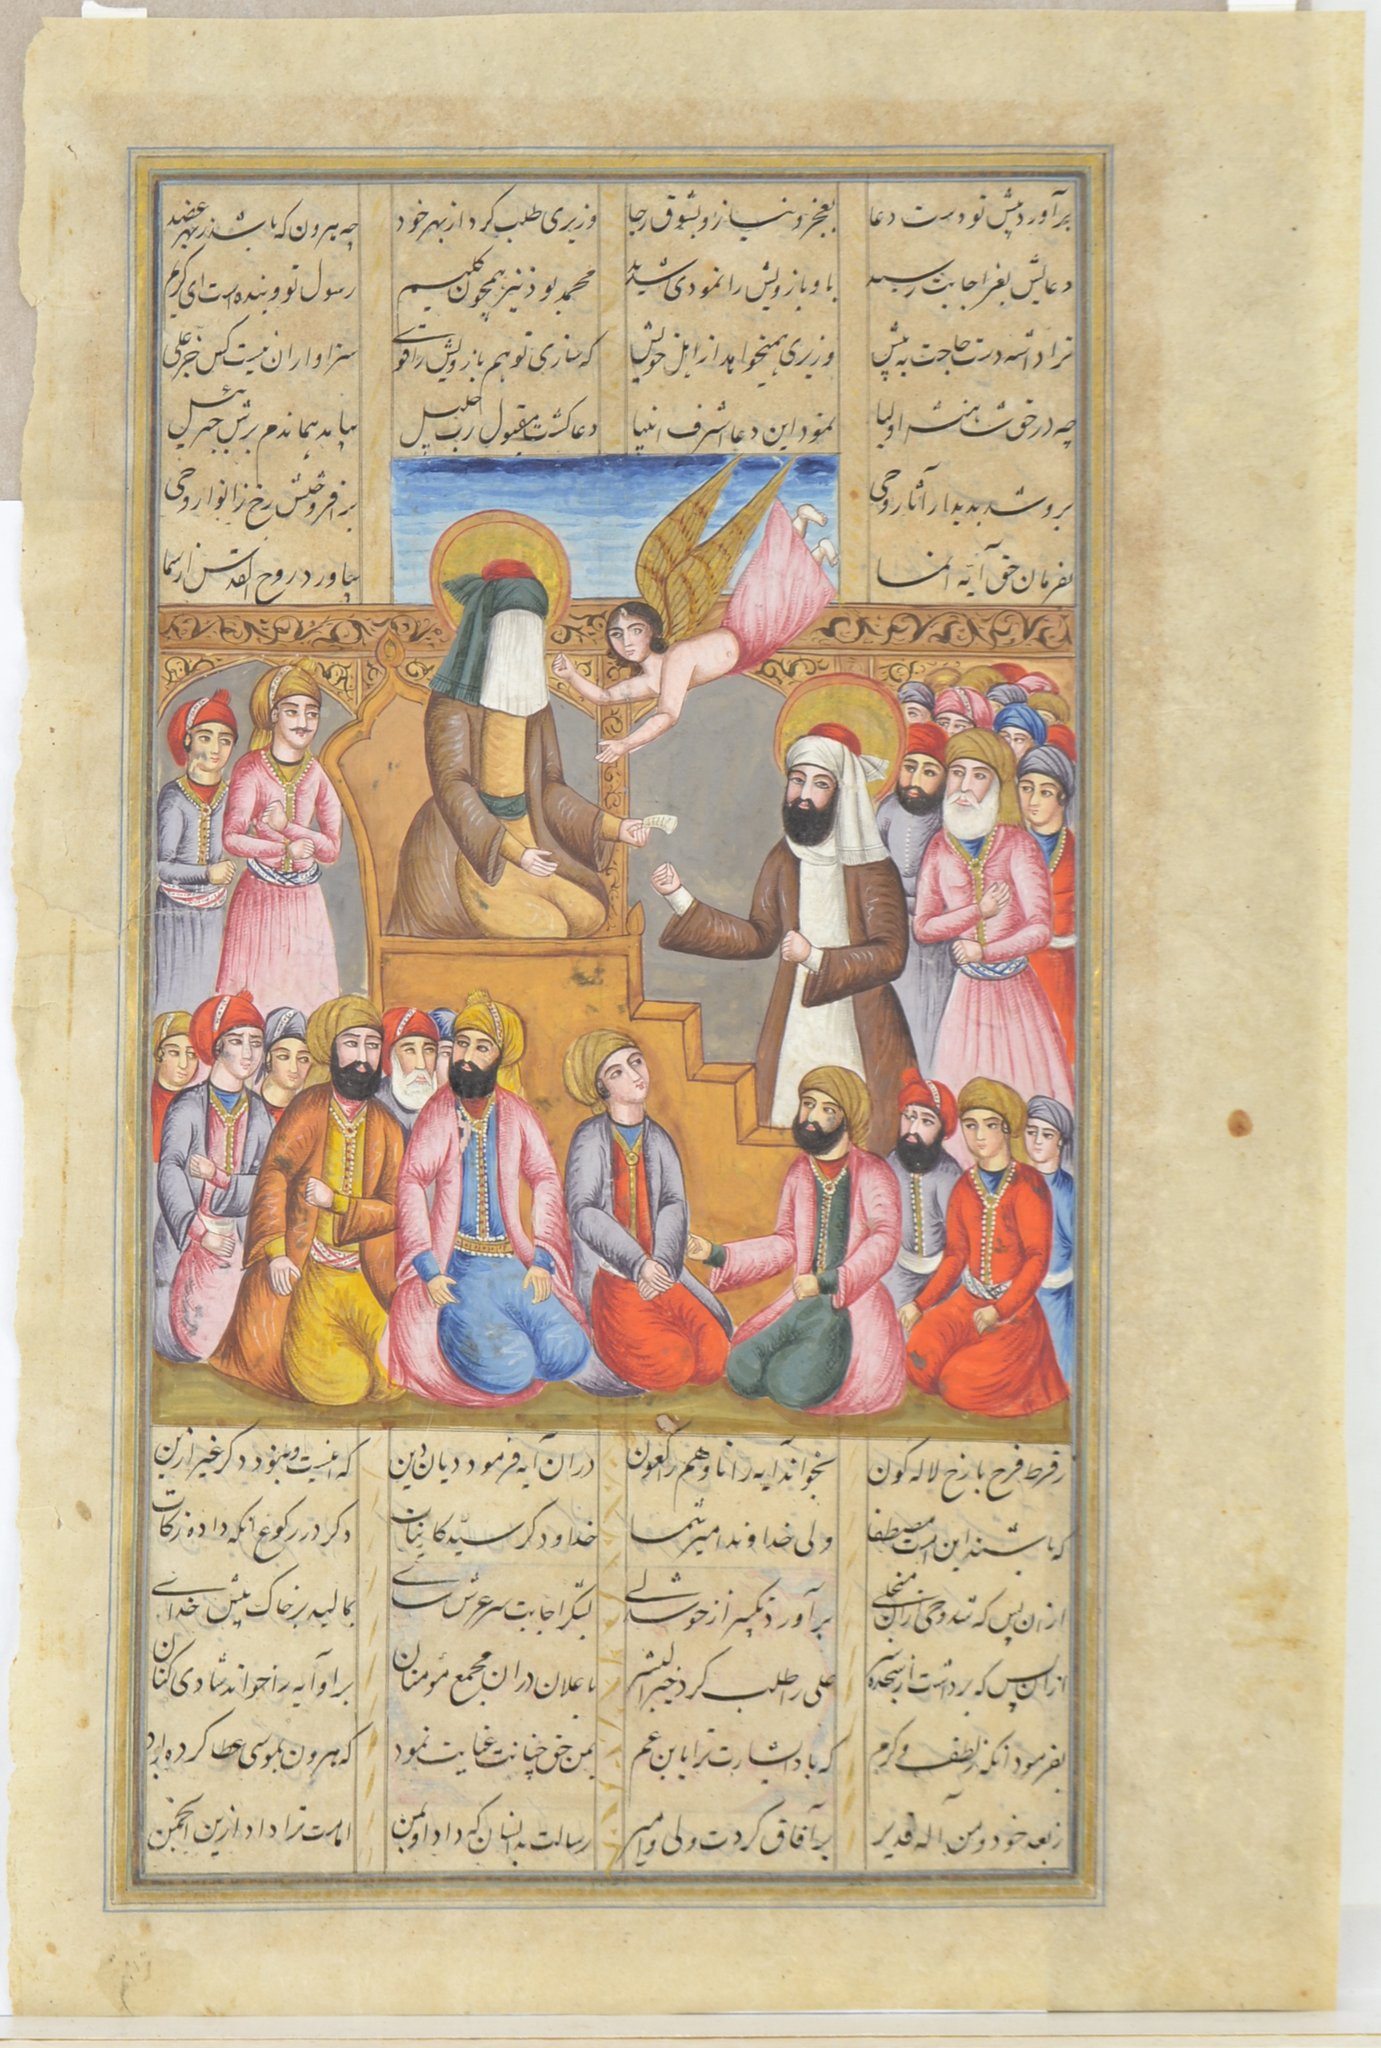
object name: folio from an illustrated manuscript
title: "The Angel Gabriel Reveals Sura Annama 55 to the Prophet," Folio from a Hamla-yi Haidari (Attack of the Lion)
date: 1801-1900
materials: gold, ink, paper, watercolor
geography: iran